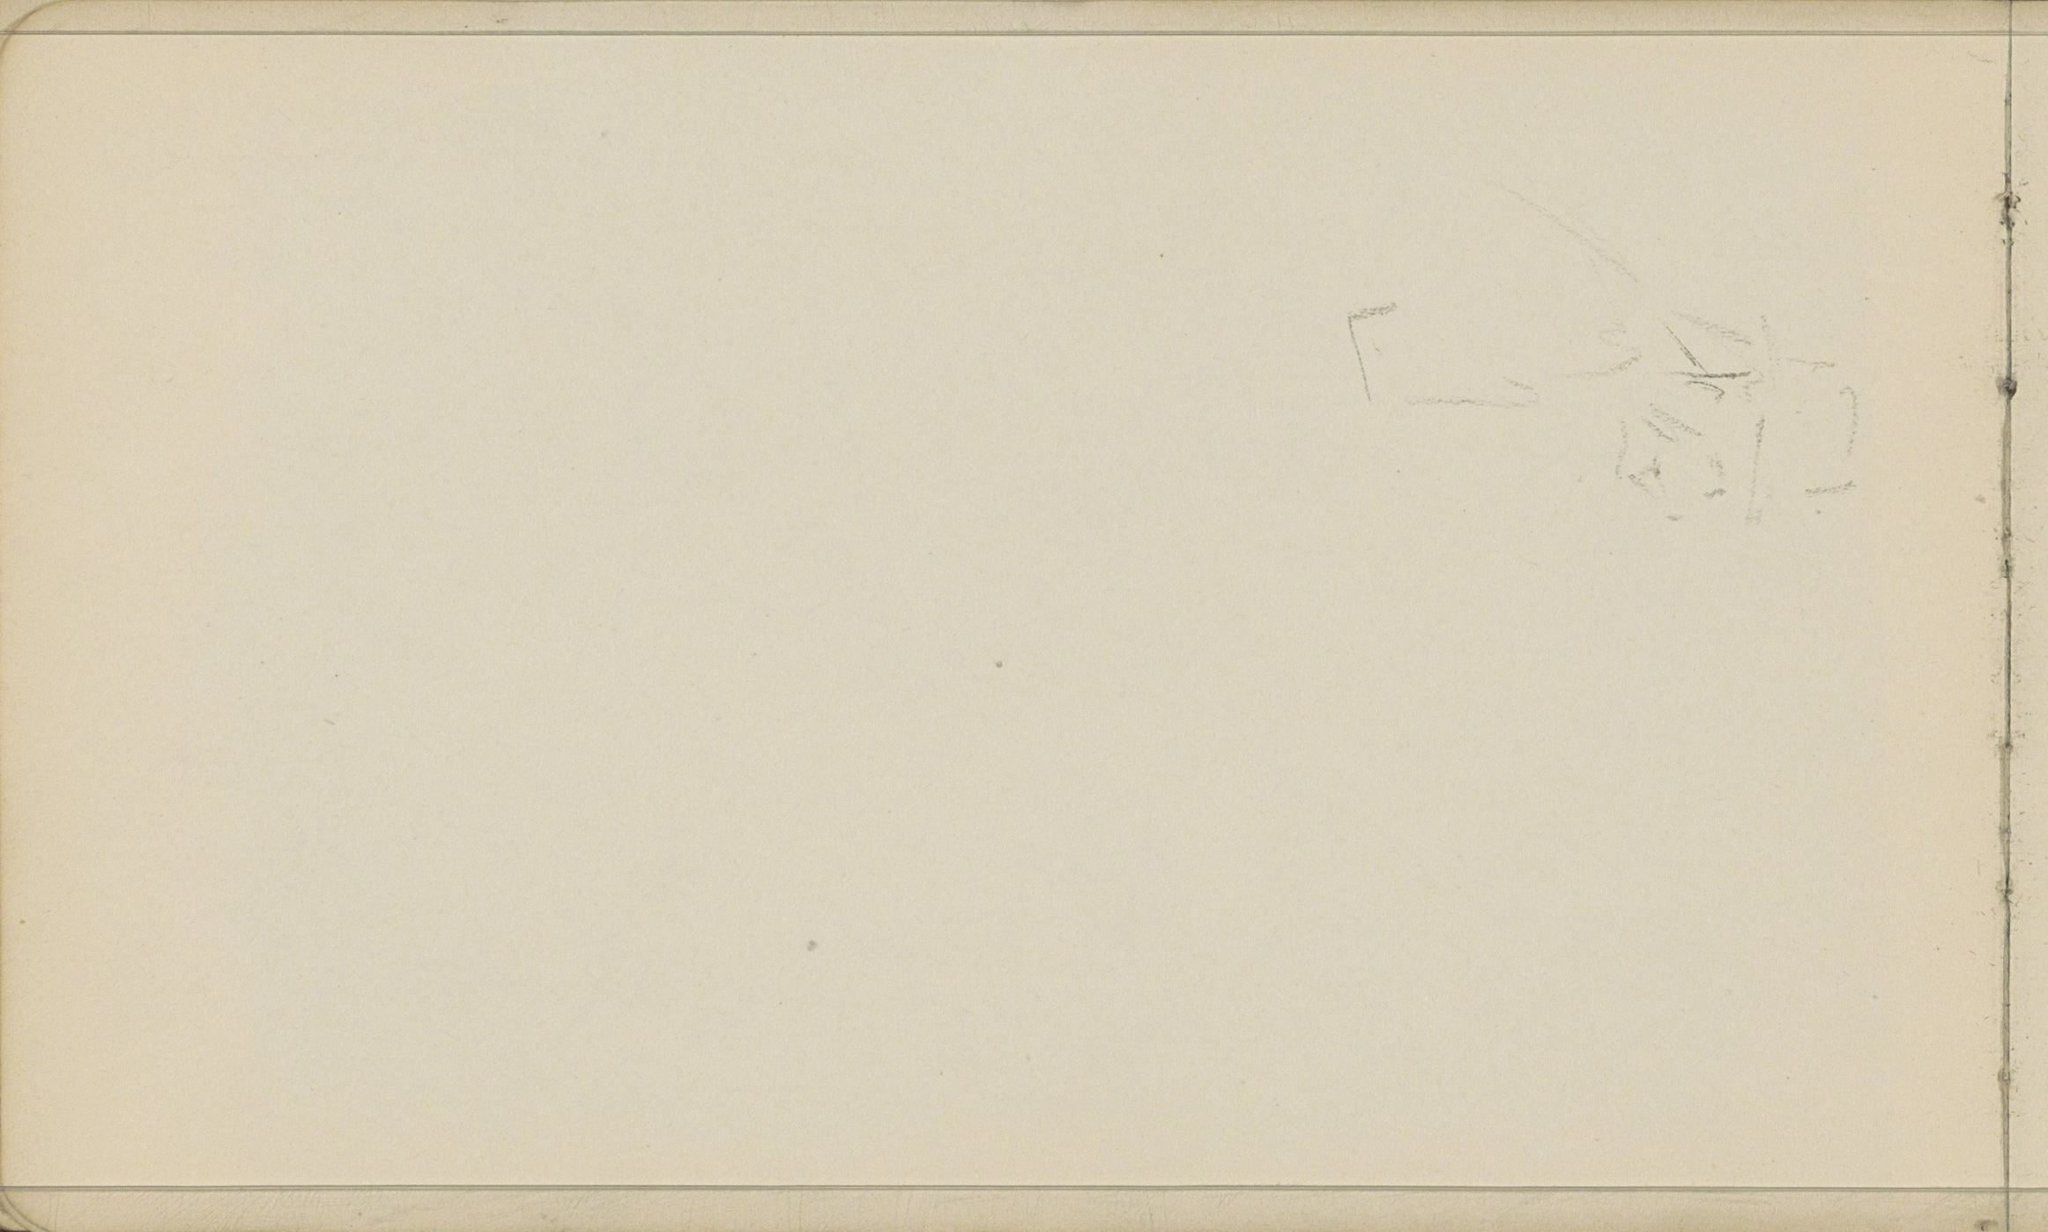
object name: sketchbook leaf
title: Man met hoed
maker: johan antonie de jonge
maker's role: draughtsman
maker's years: 1864-1927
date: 1881-1927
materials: chalk, paper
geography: south holland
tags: adult man (+ sideview, profile)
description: Man met hoed, in profiel naar rechts. Blad 29 verso uit een schetsboek met 34 bladen.